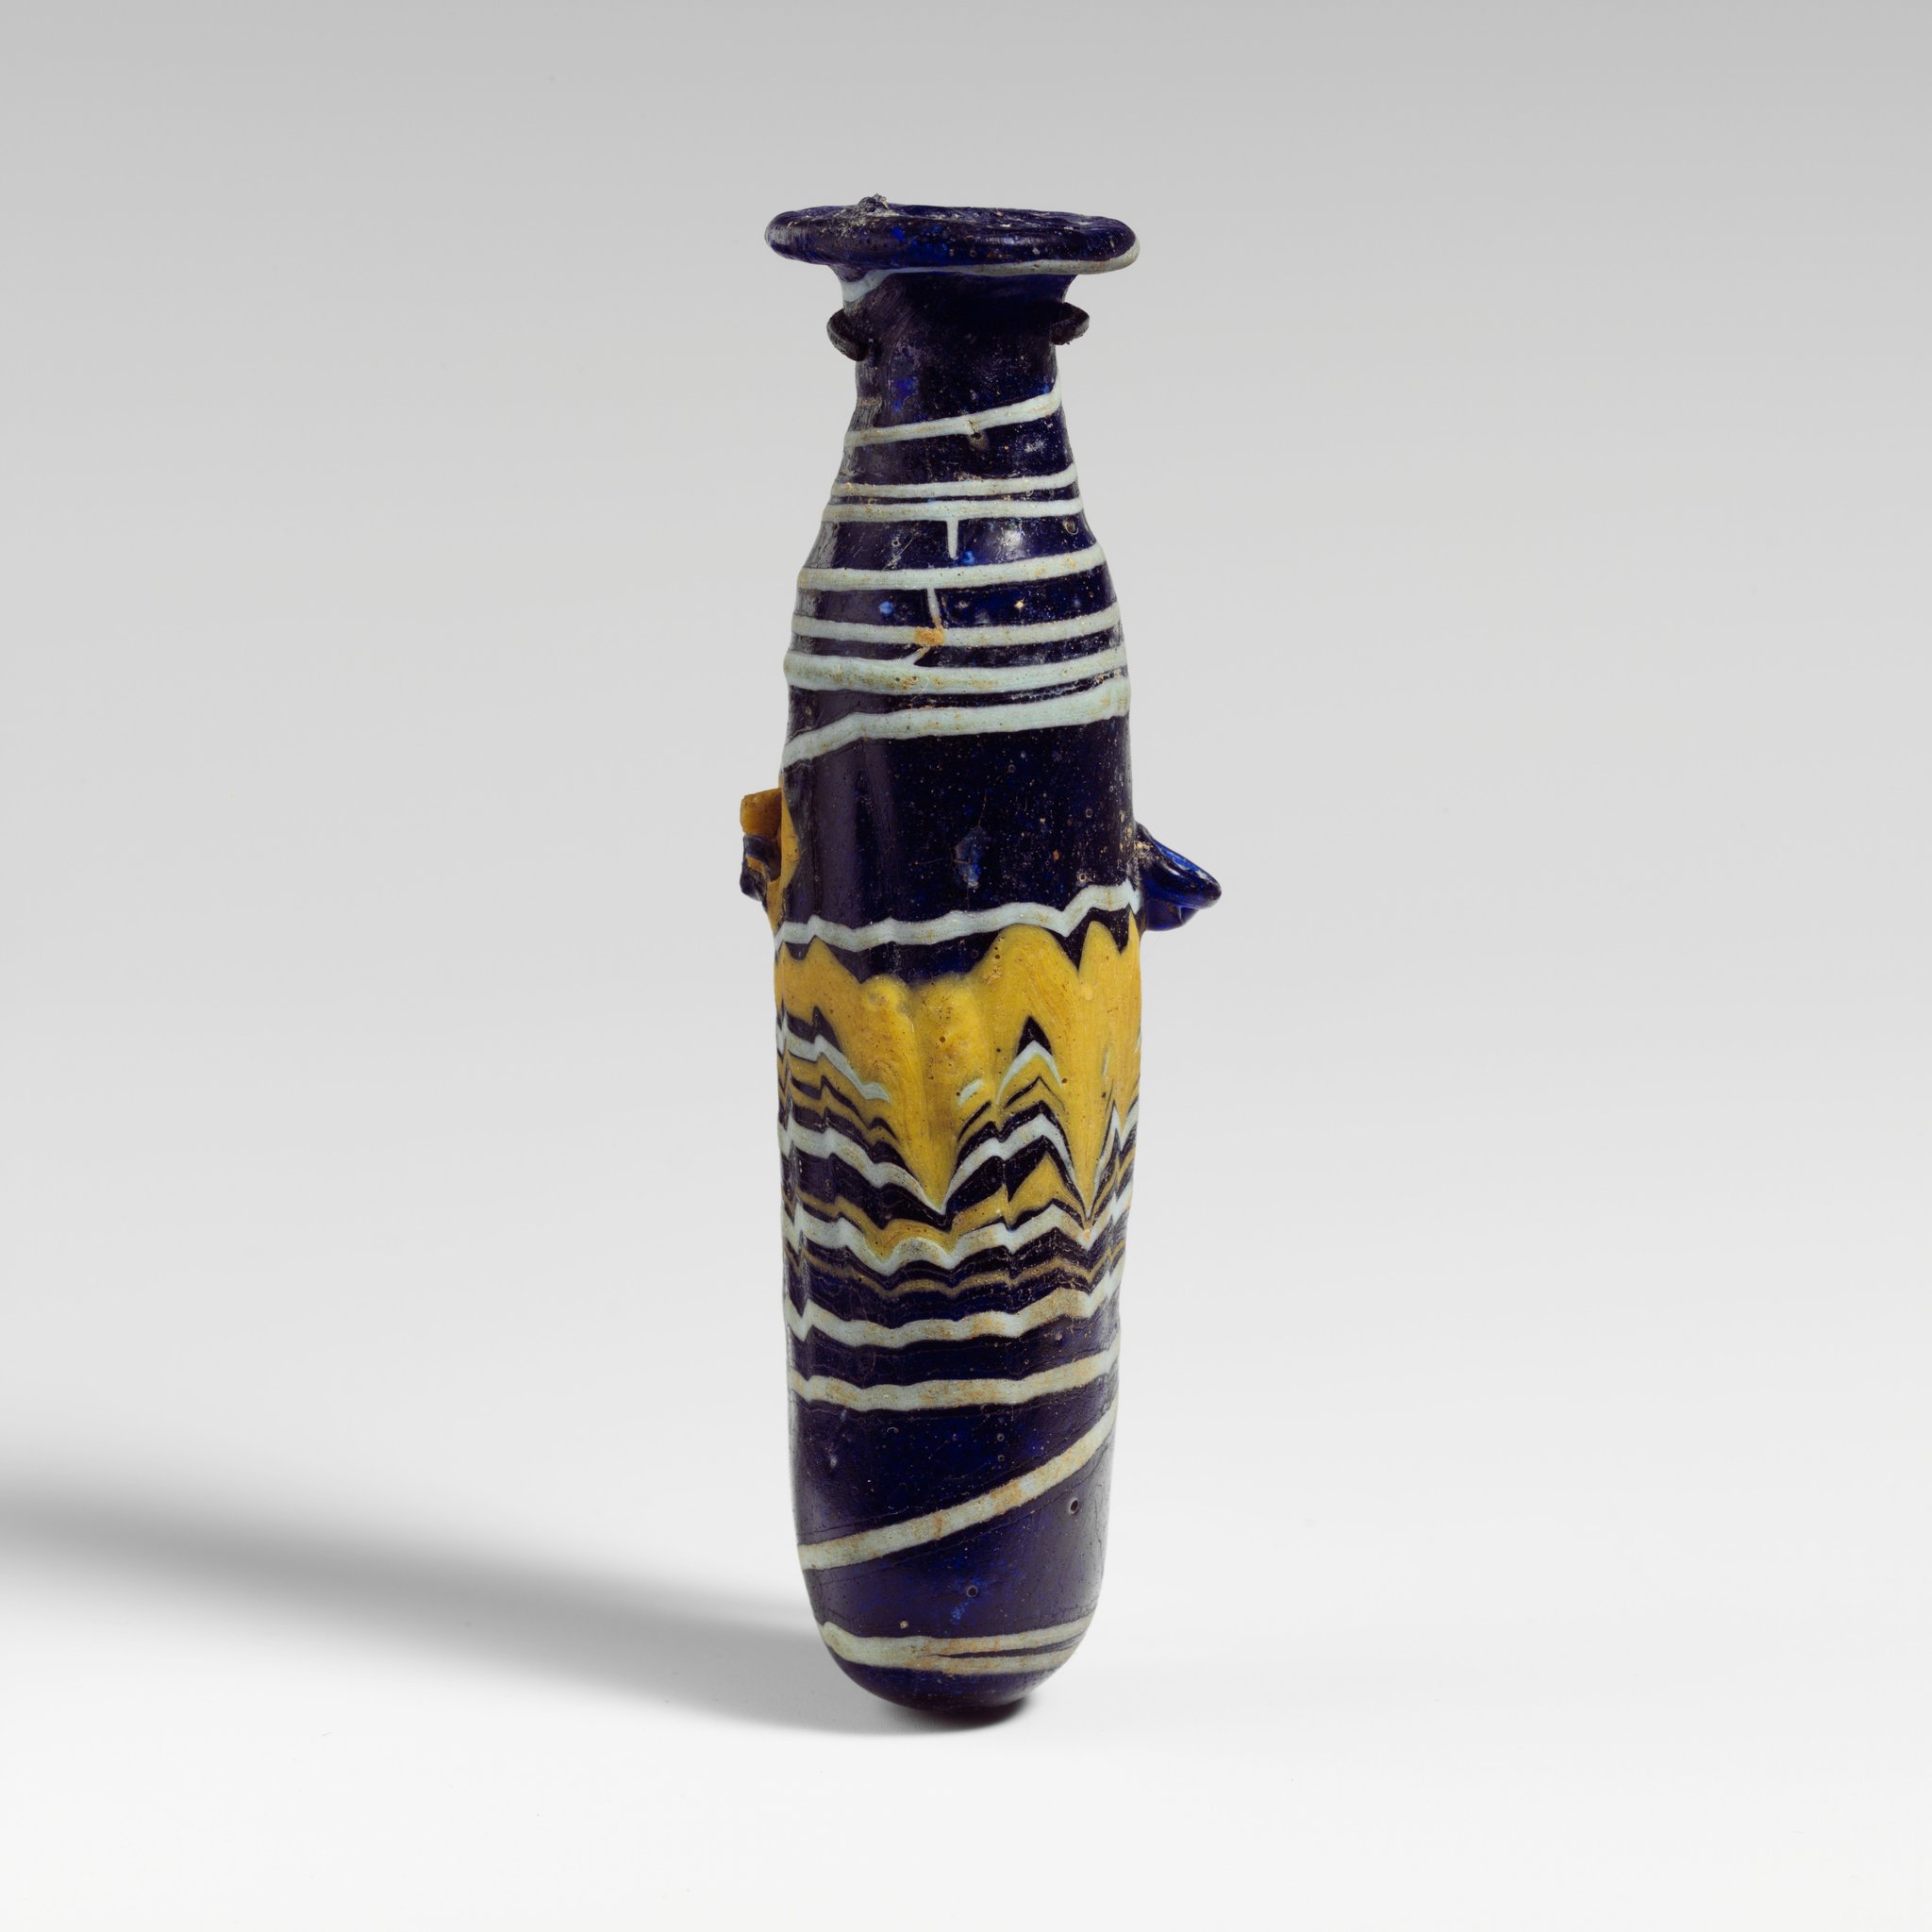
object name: alabastron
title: Glass alabastron (perfume bottle)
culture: greek, eastern mediterranean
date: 334-268 BCE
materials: glass